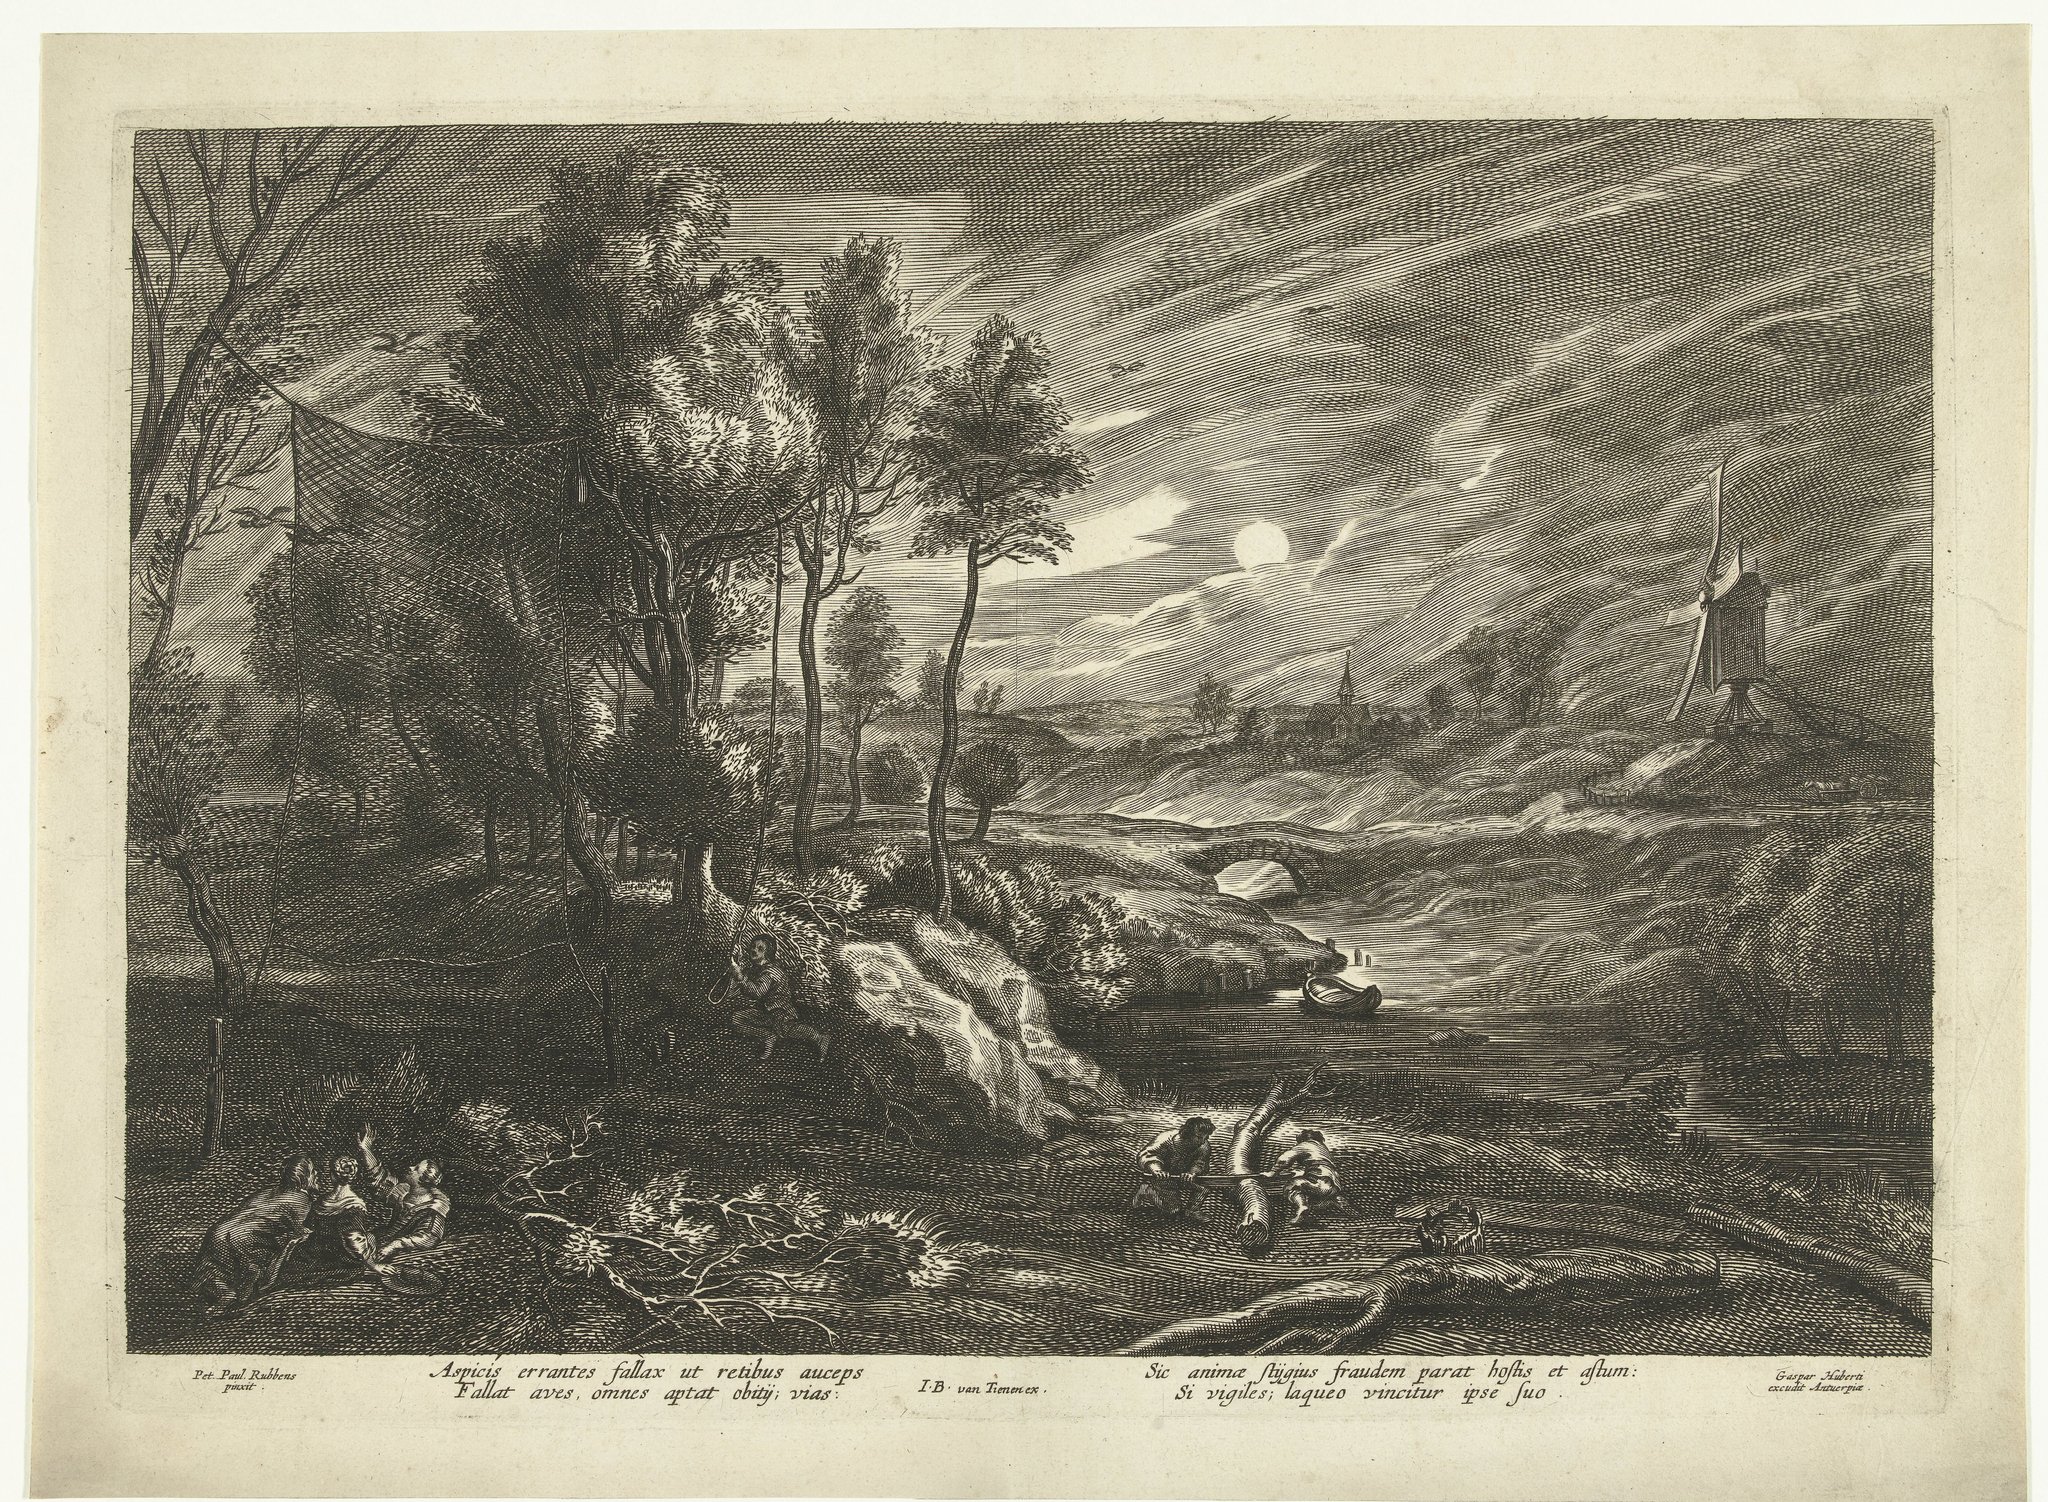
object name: print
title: Landschap met houtsnippenvanger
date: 1596-1684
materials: paper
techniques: engraving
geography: antwerp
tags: bird hunting, windmill in landscape, shore-birds and wading-birds: woodcock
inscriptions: collector's mark: Lugt 2228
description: Landschap met een vogelvanger (of snippenflouwer) die een staand net heeft gespannen tussen bomen voor de houtsnippenvangst (het net is een zogenaamde laatflouw) welke hij met een touw vasthoudt. In de ochtend- of avondschemer wacht hij op de in de lucht naderende houtsnippen die weldra in het net zullen vliegen. Een klein publiek kijkt toe. In het door de maan beschenen landschap staat een molen. Met vier regels tekst in Latijn.